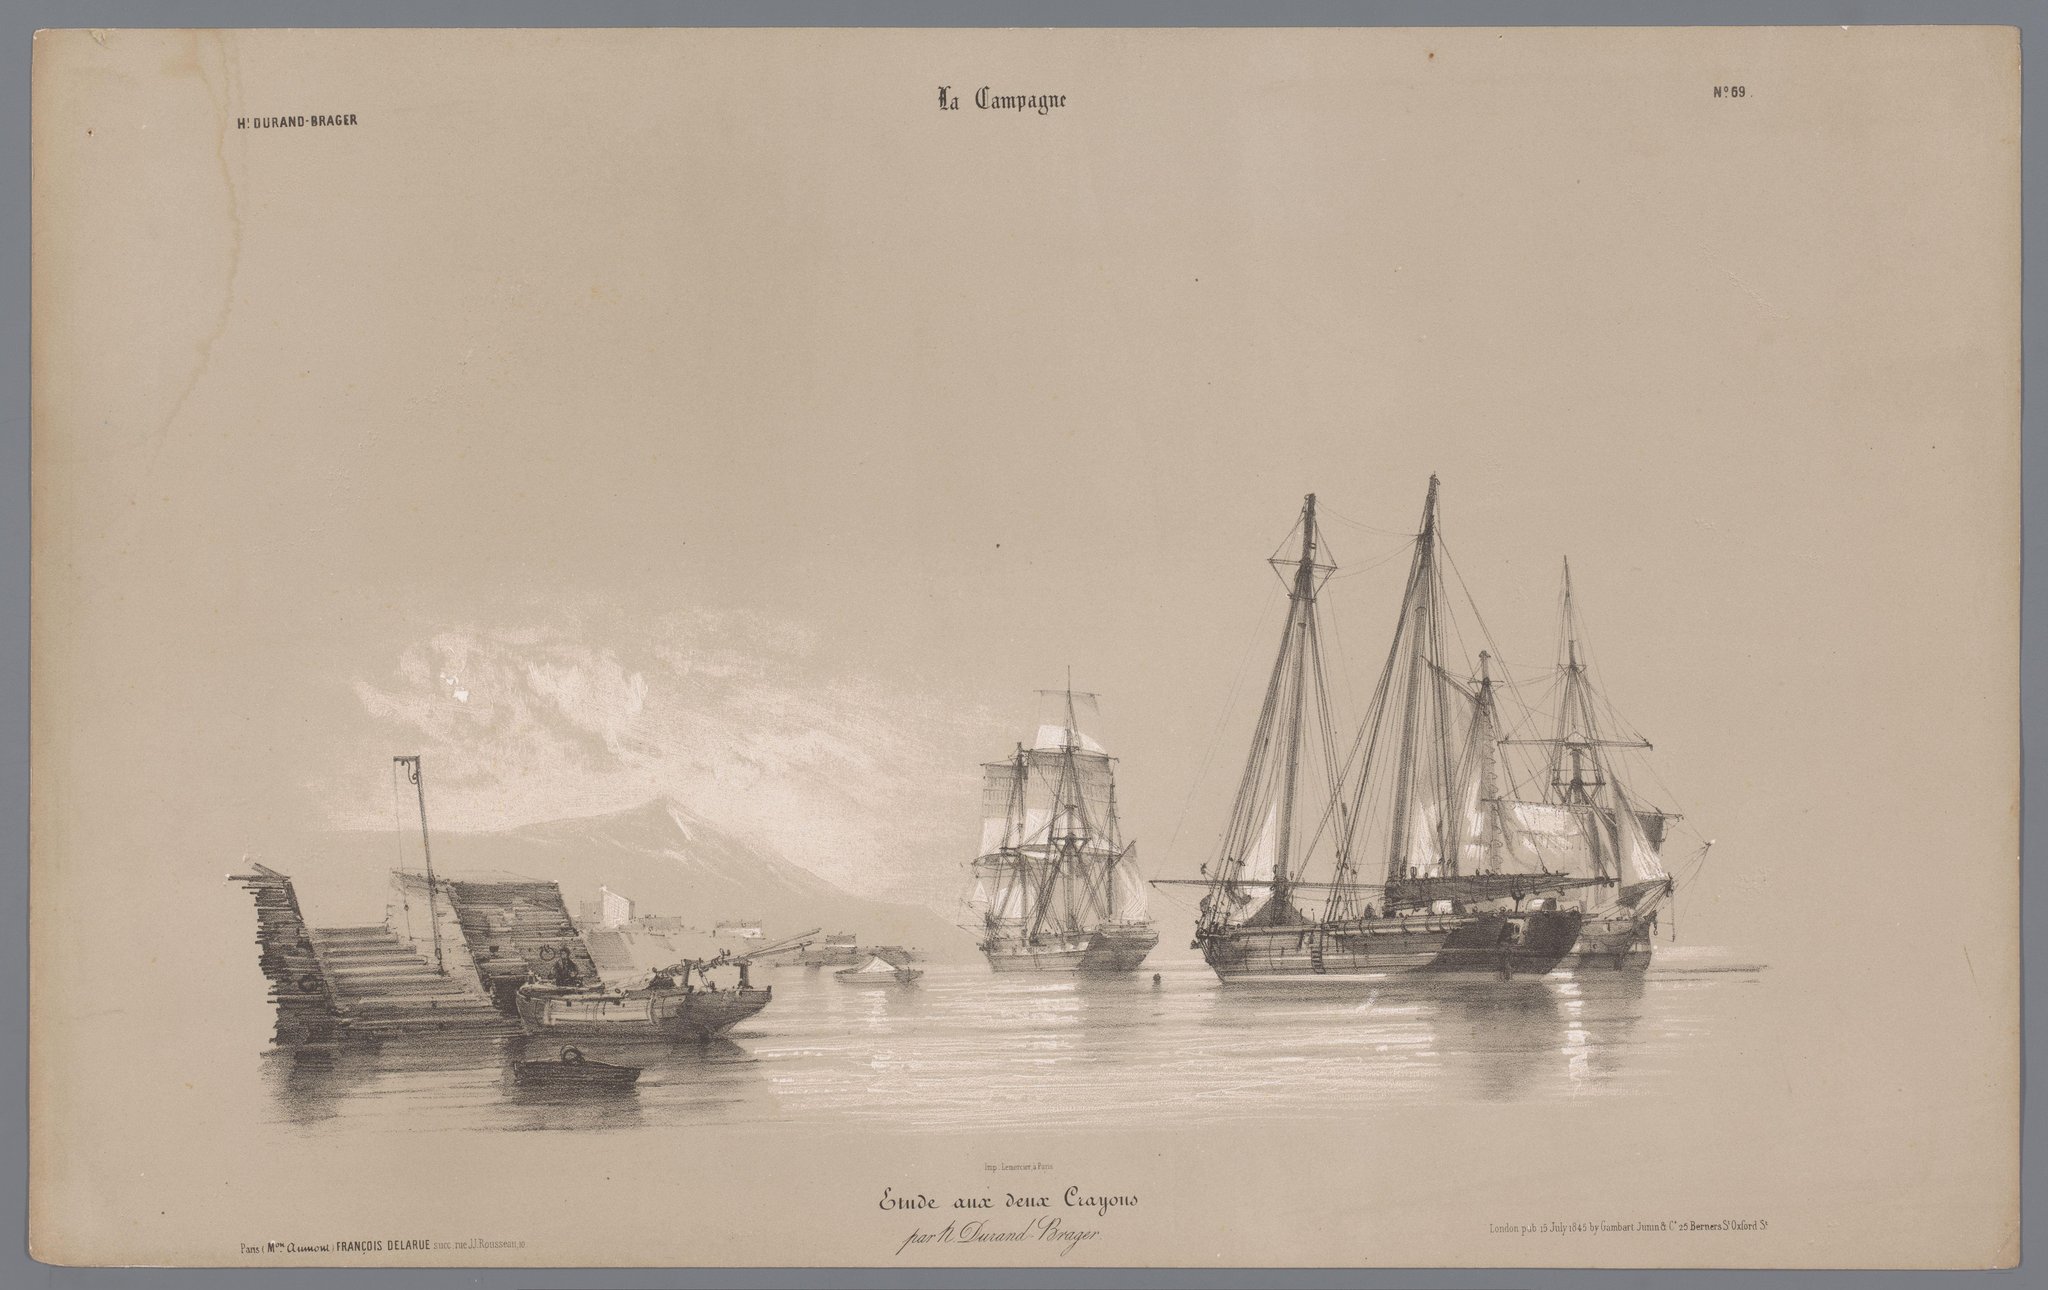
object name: print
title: Voorstellingen van het leven op het platteland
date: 1844-1845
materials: paper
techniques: tone lithography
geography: london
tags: harbour, sailing-ship, sailing-boat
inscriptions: collector's mark: Lugt 2228a